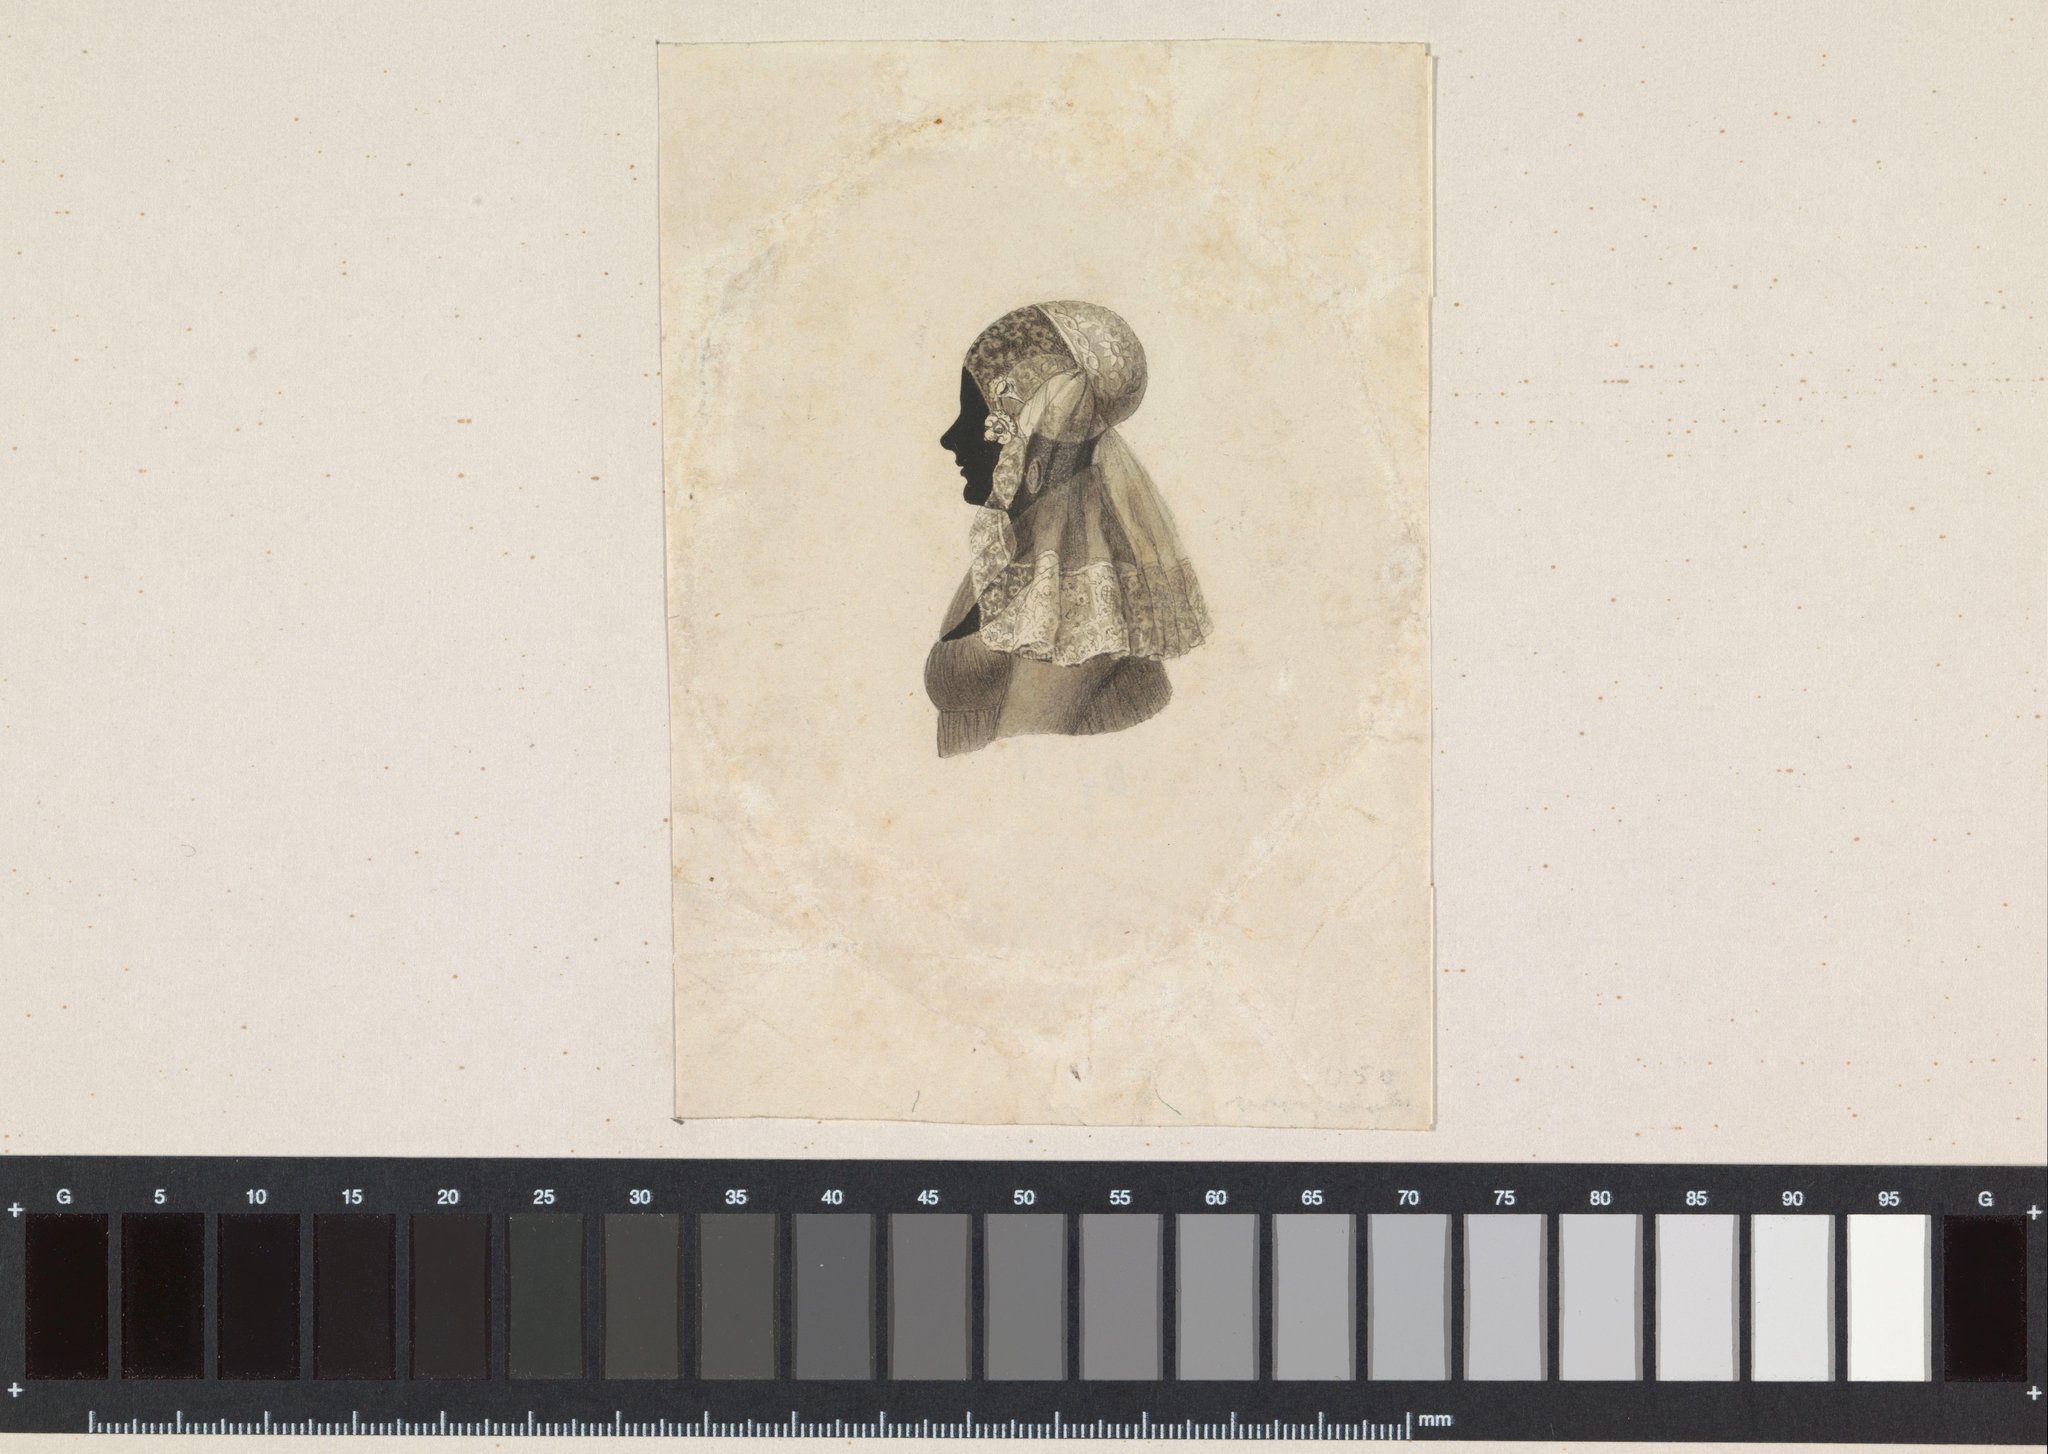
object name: drawing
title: Silhouet van een Friezin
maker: gerrit jacobus geusendam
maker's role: draughtsman, painter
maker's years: 1771-1842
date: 1806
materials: paper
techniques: brush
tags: anonymous historical person portrayed alone, female sex; woman